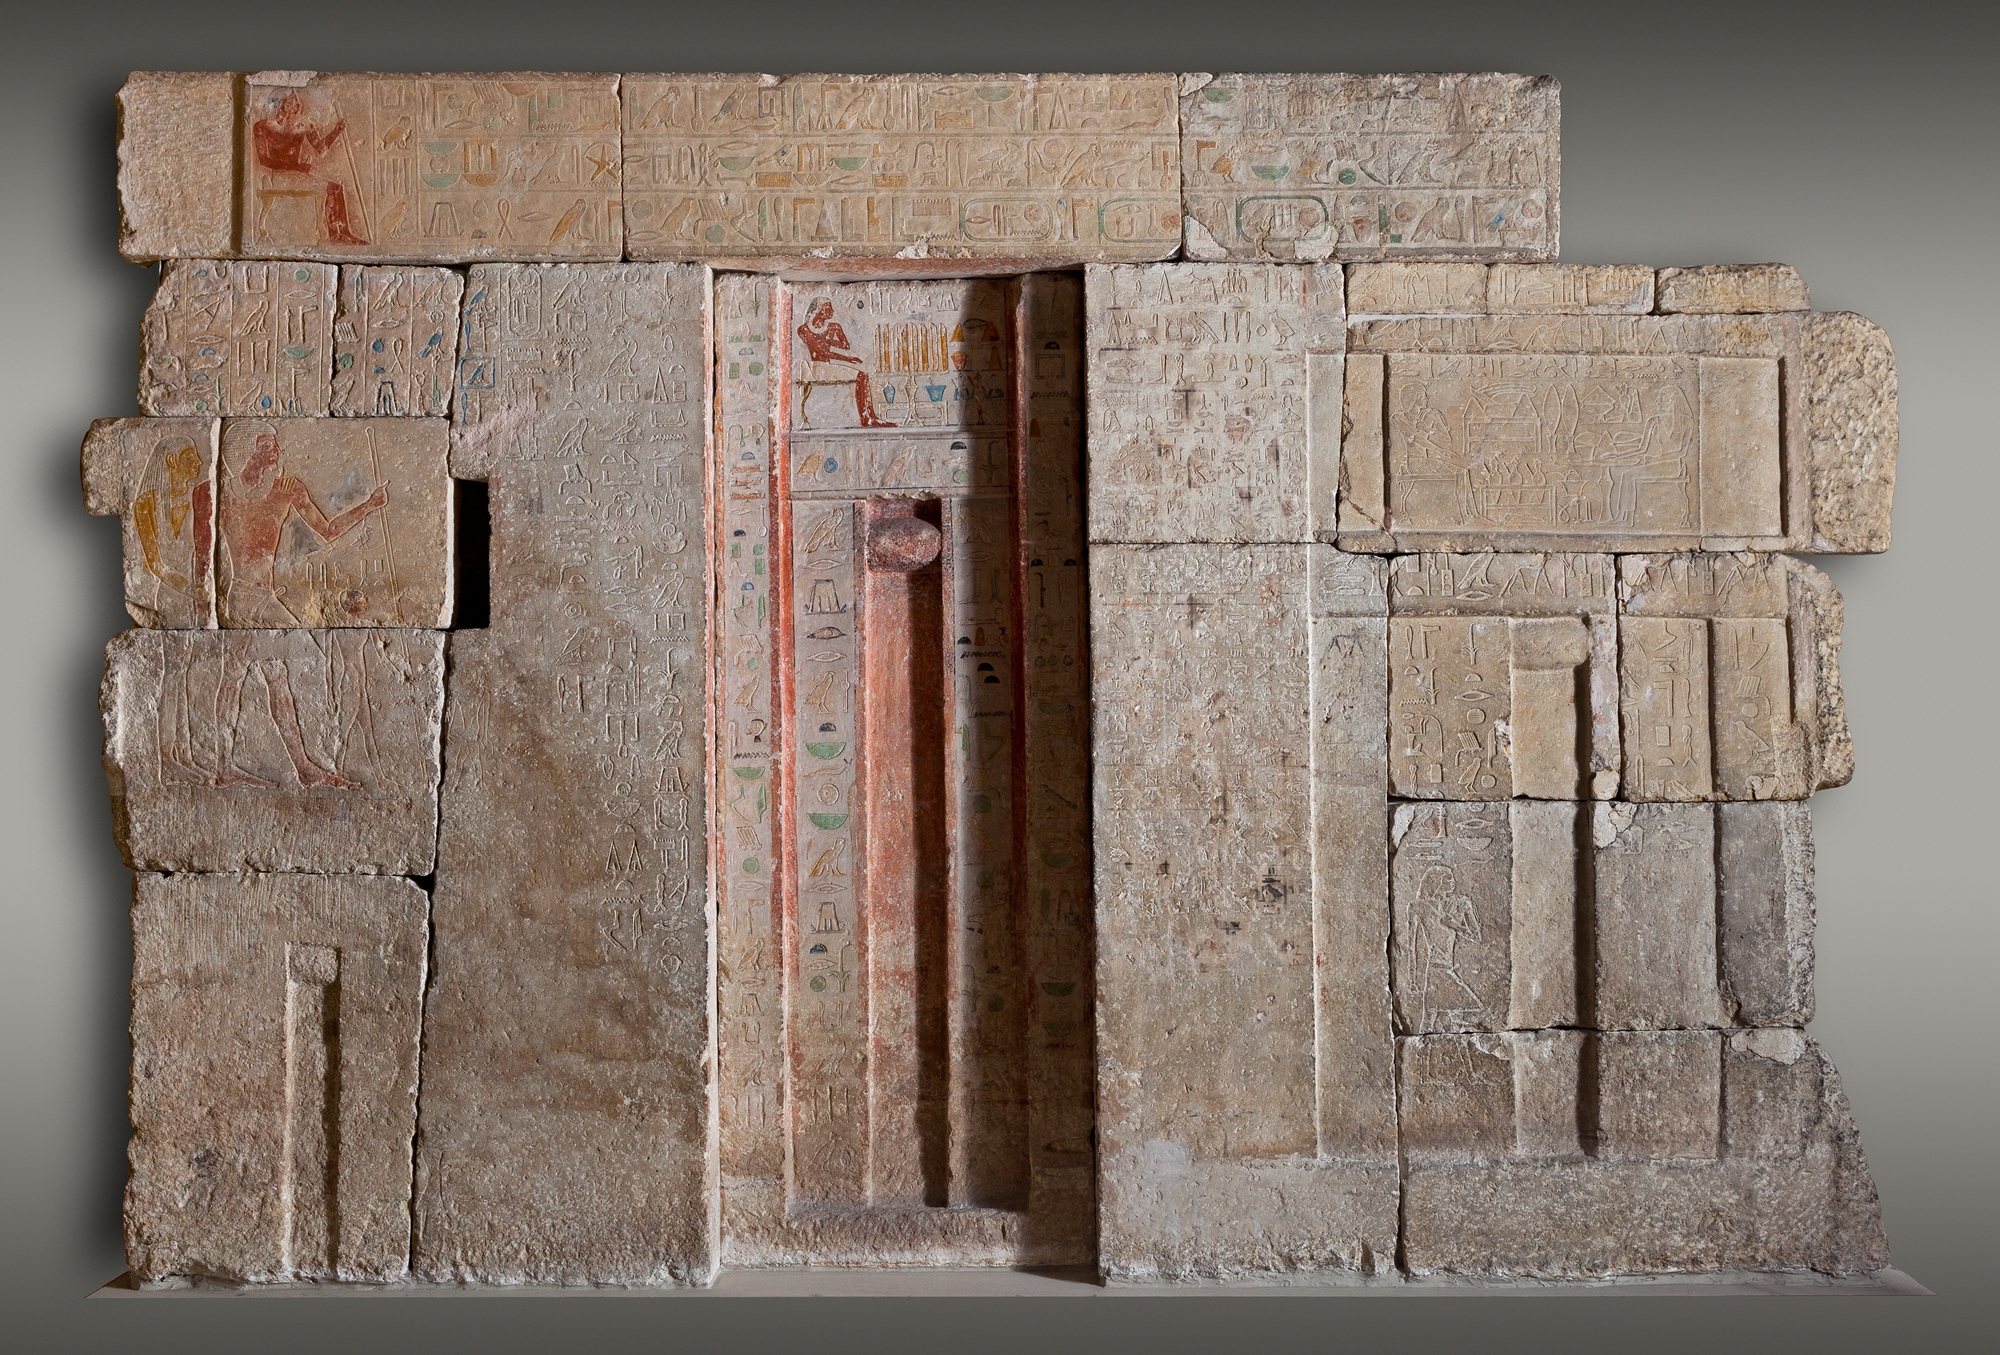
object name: relief, chapel of kaemsenu, iretnub, kaemsenu, werdjedptah niche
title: West wall of the chapel of Kaemsenu with niches for Iretnub, Kaemsenu and Werdjedptah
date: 2420-2250 BCE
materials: limestone, paint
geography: egypt